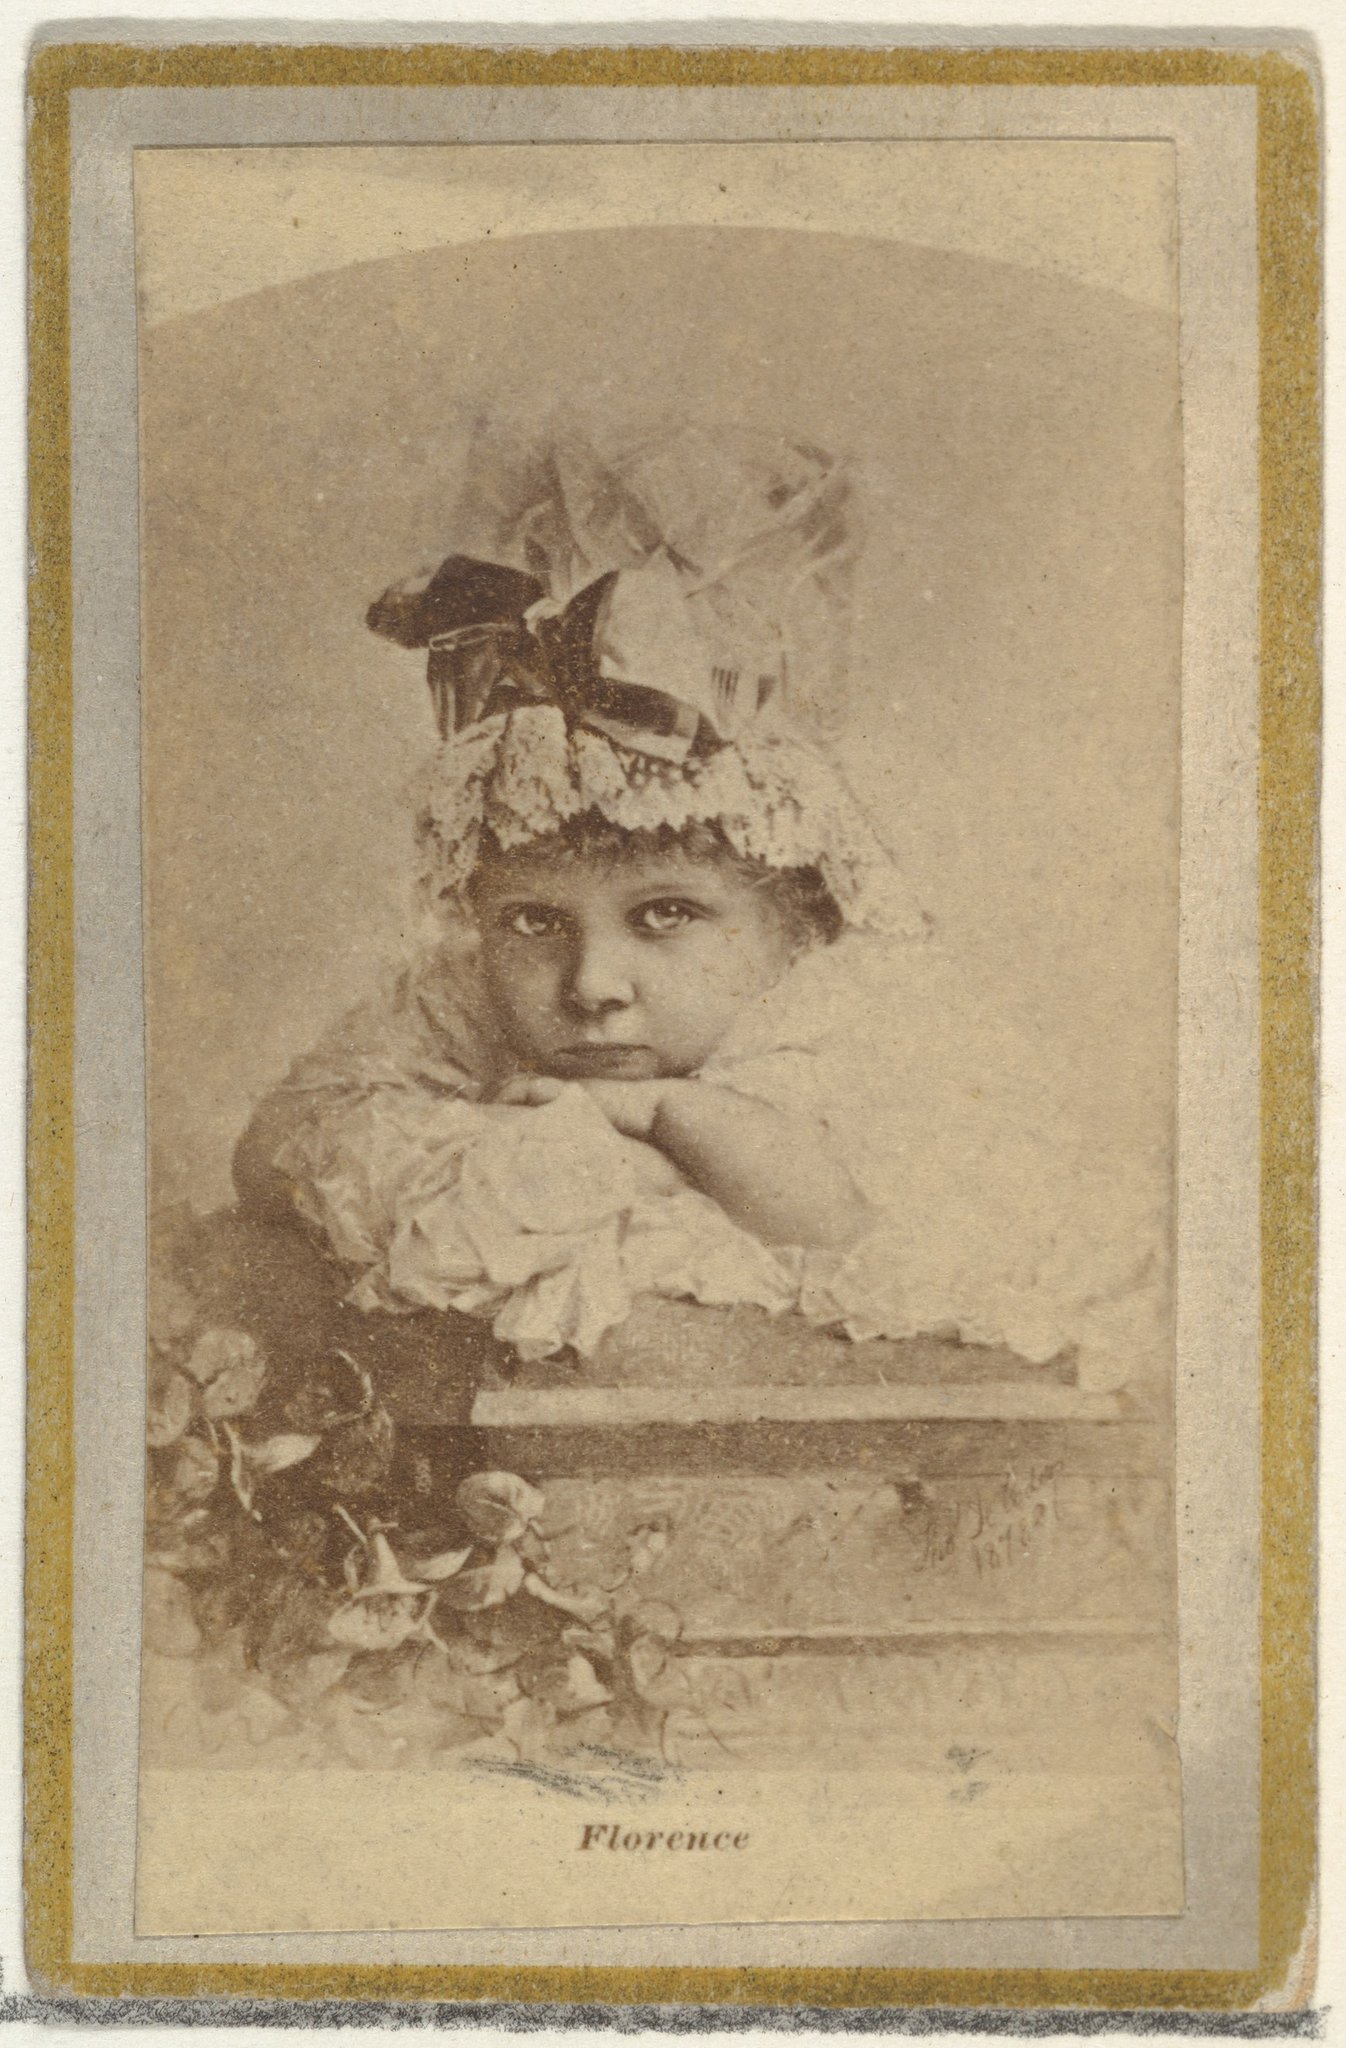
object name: photograph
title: Florence, from the Actresses and Celebrities series (N60, Type 2) promoting Little Beauties Cigarettes for Allen & Ginter brand tobacco products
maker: allen & ginter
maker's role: publisher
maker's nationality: american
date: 1887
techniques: albumen silver print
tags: girls,portraits,actresses